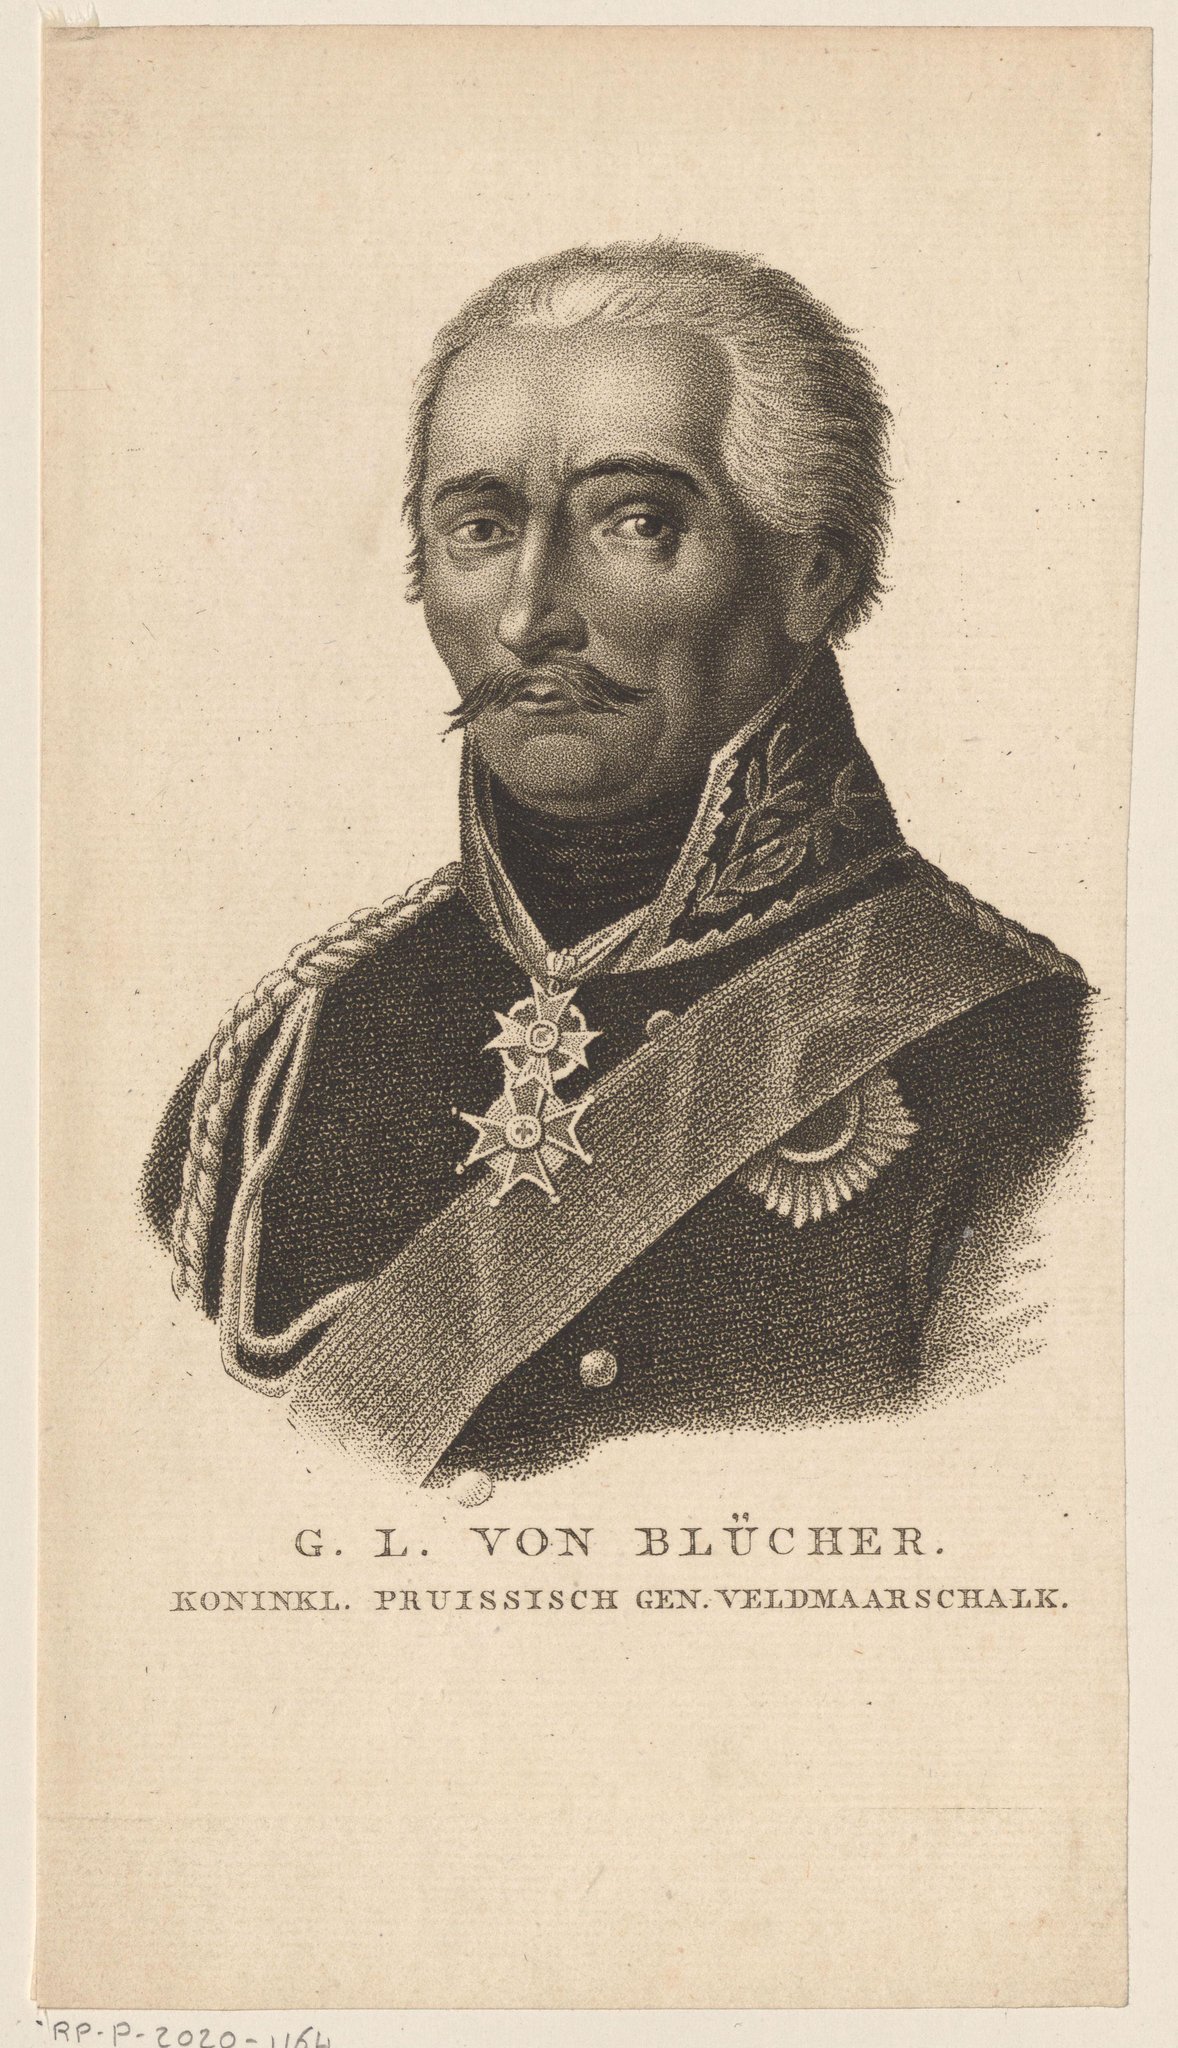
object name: print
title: Portret van Gebhard Leberecht von Blücher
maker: Anonymous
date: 1813-1849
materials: paper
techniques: etching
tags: commander-in-chief, general, marshal, historical persons